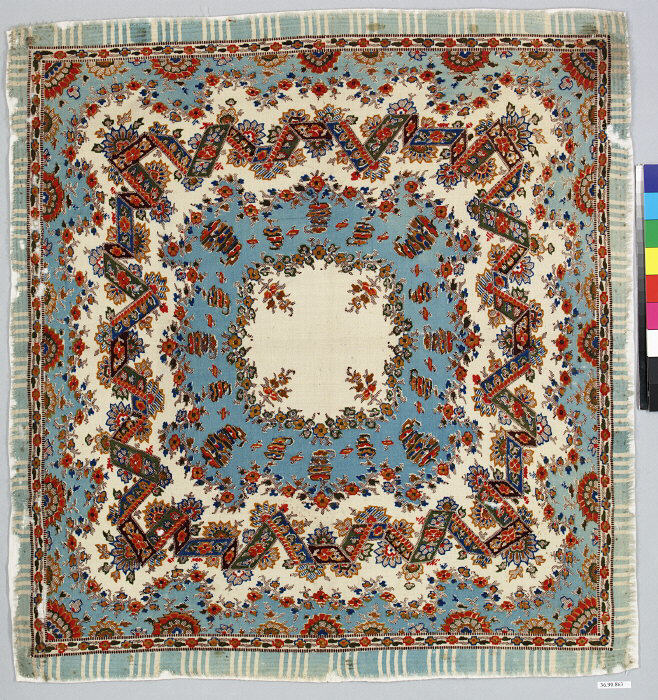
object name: kerchief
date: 1801-1900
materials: wool